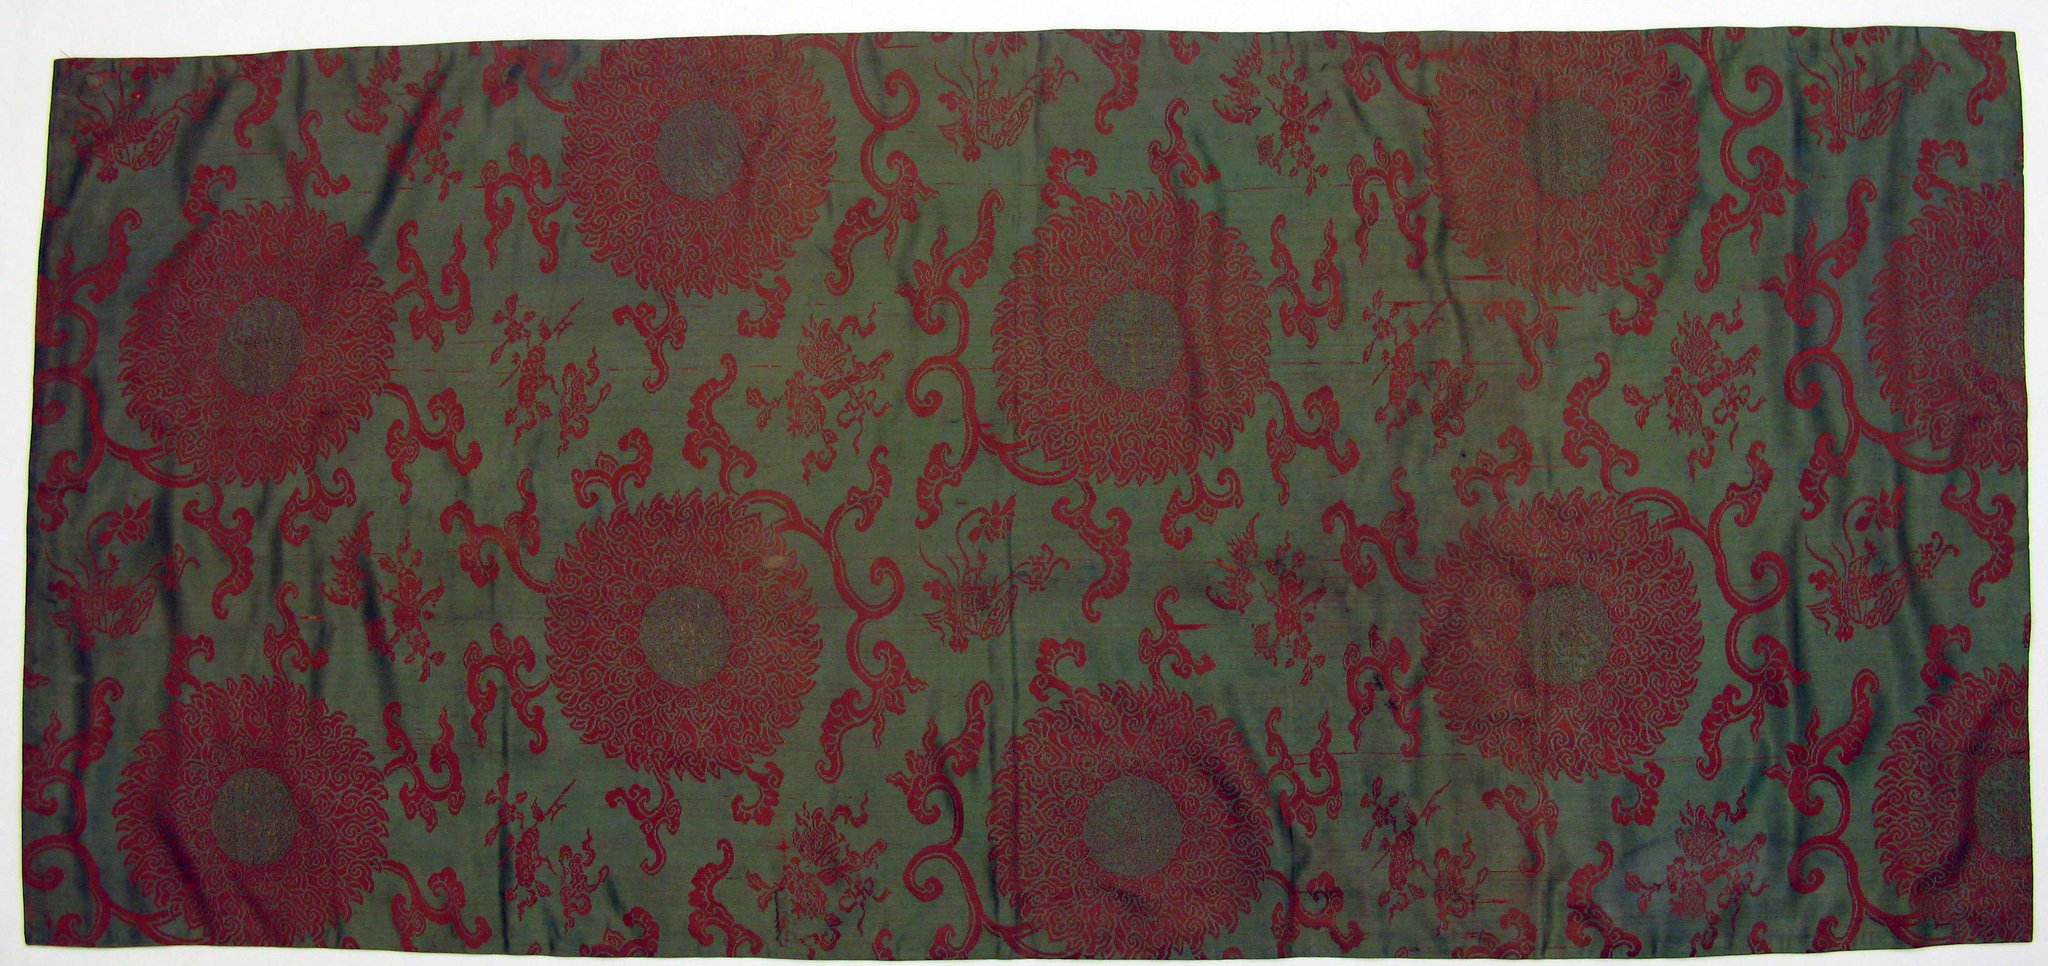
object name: length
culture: chinese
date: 1701-1800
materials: metal thread, silk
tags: flowers